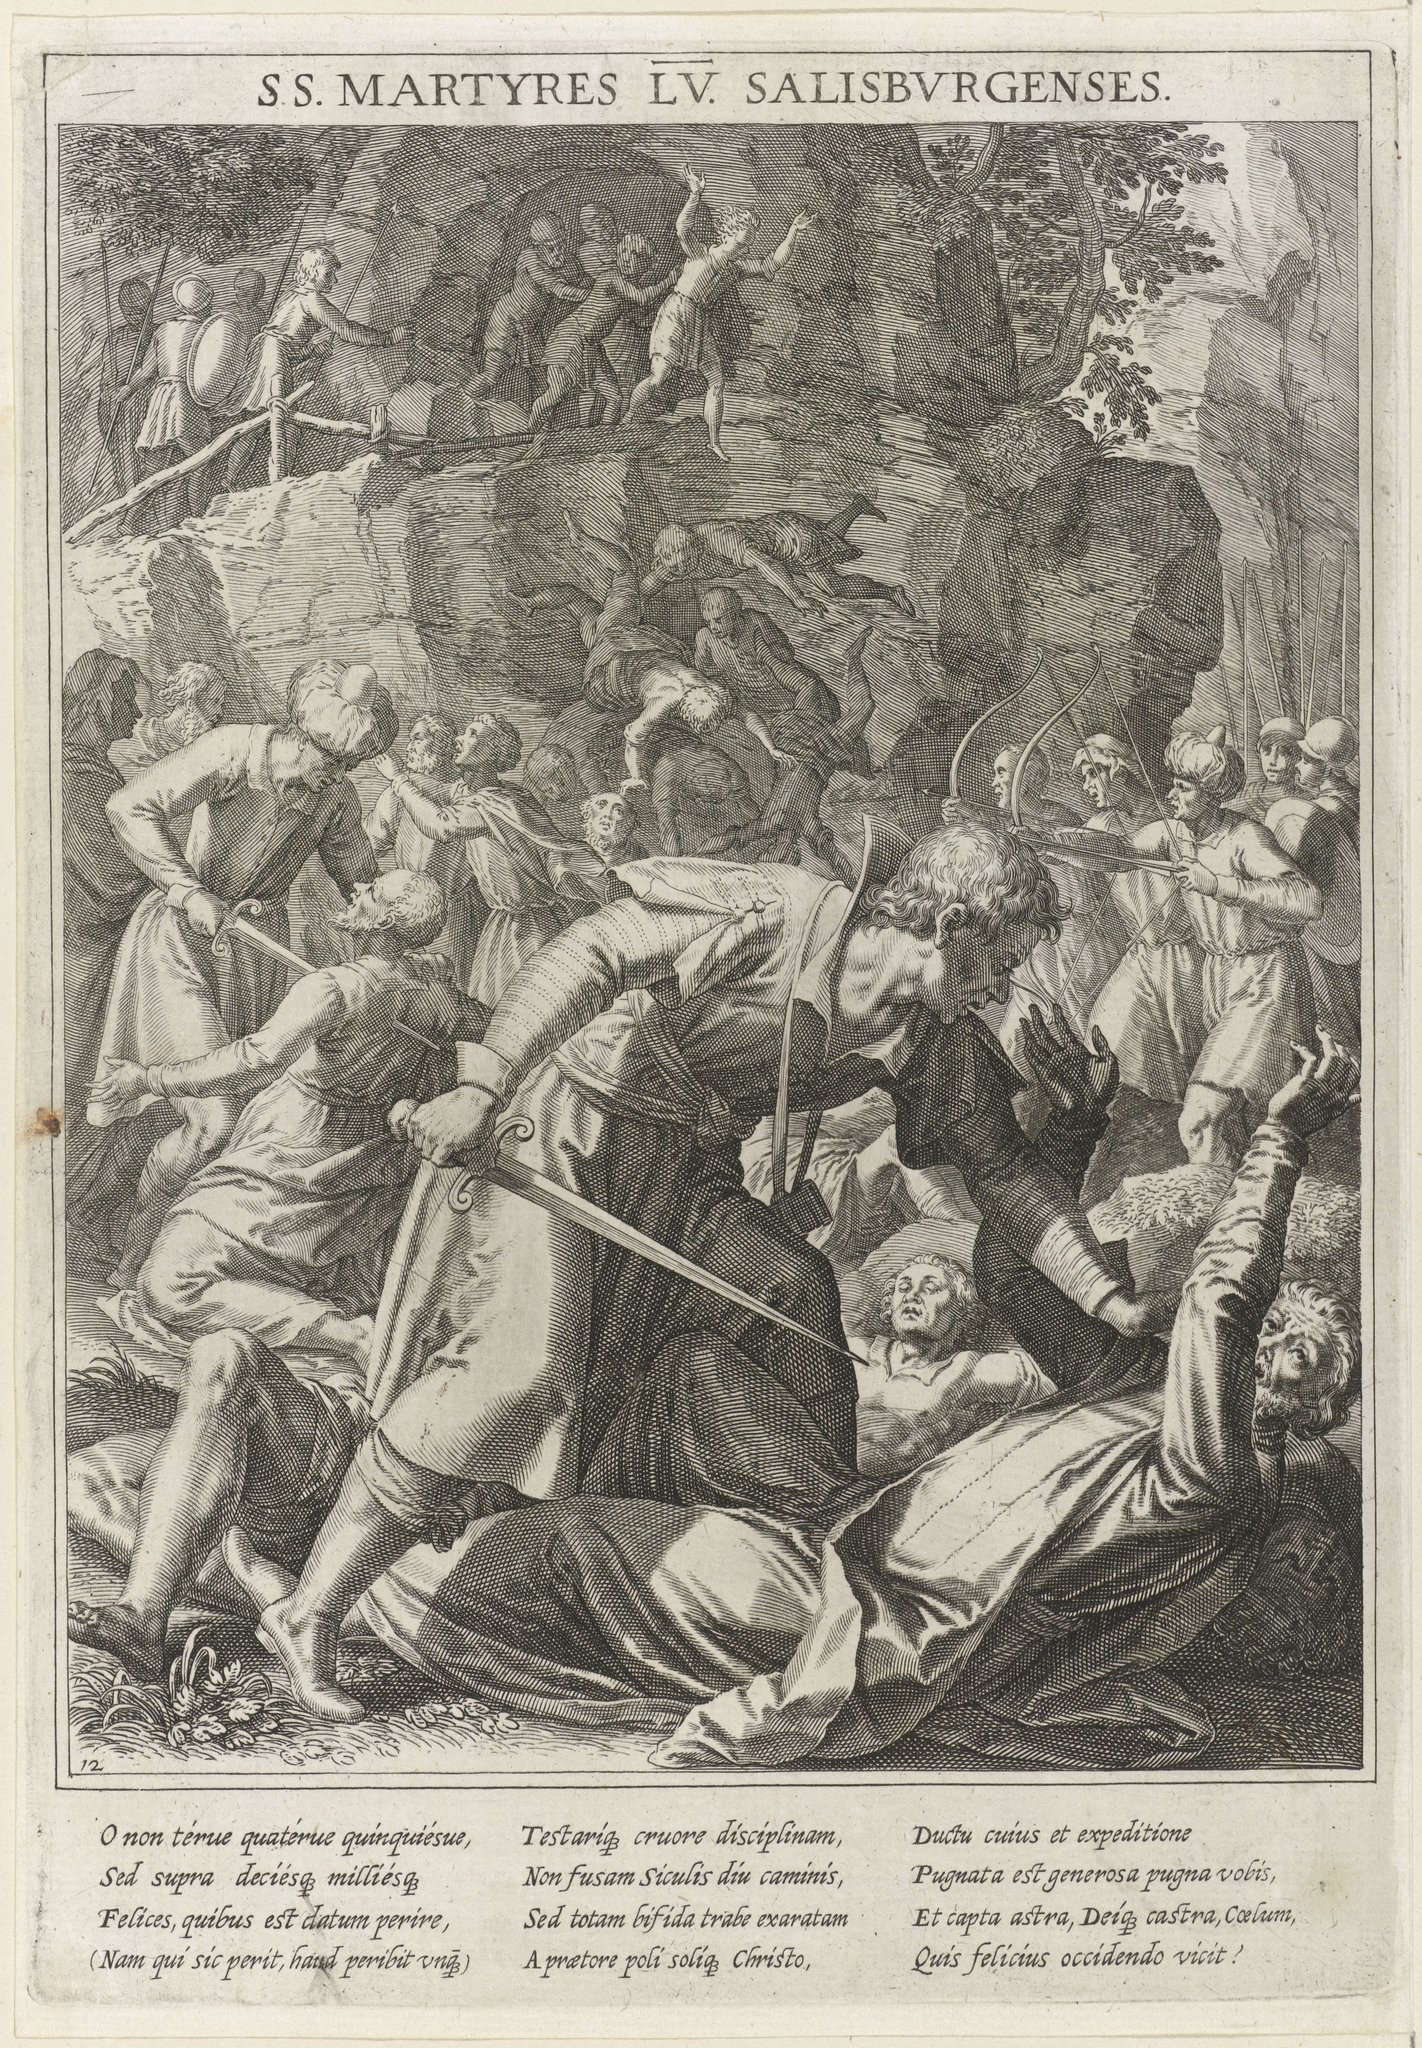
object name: print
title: Marteldood van de 55 christenen van Salzburg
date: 1615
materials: paper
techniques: engraving, etching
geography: munich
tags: violent death by weapon, saints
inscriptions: collector's mark: Lugt 240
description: De 55 martelaren van Salzburg worden door de Germaanse stam de Herulen omgebracht. De prent heeft een Latijns onderschrift en is de twaalfde prent van een 60-delige serie met als onderwerp de heiligen van Beieren.